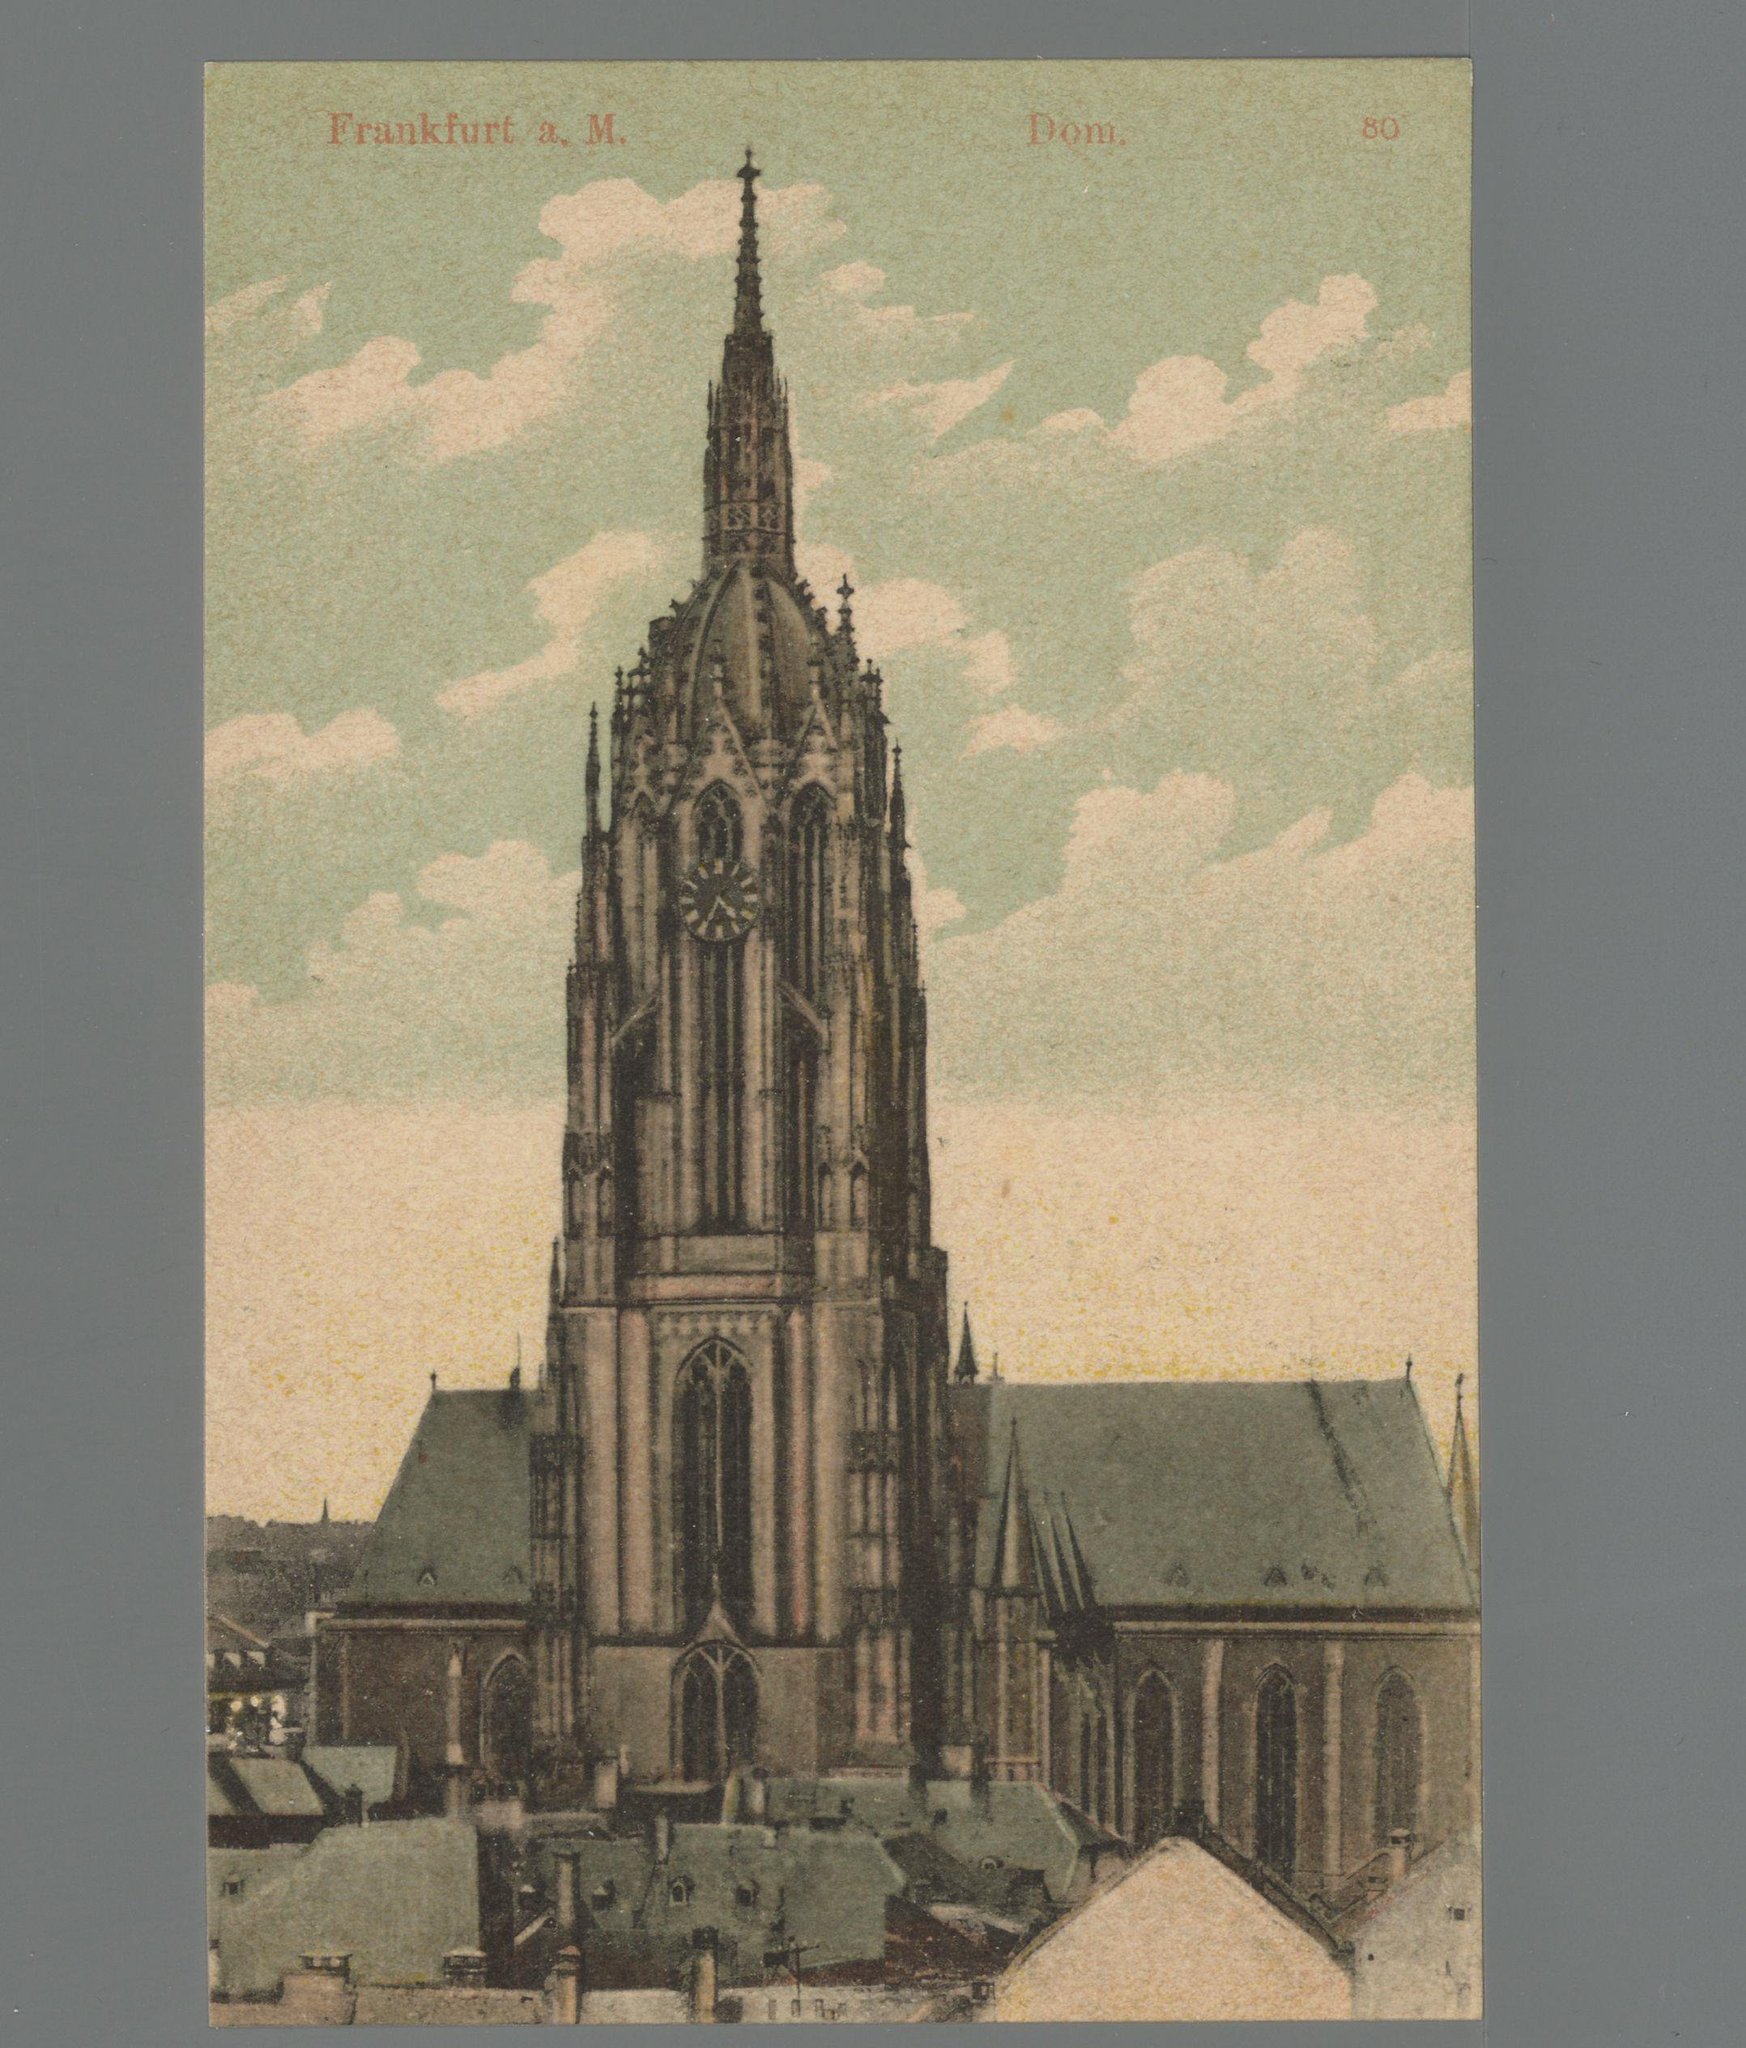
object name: ansichtkaart, prentbriefkaart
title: Frankfurt a. M. Dom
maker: Anonymous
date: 1905-1908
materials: cardboard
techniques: photograph, lithograph, writing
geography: frankfurt am main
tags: church (exterior)